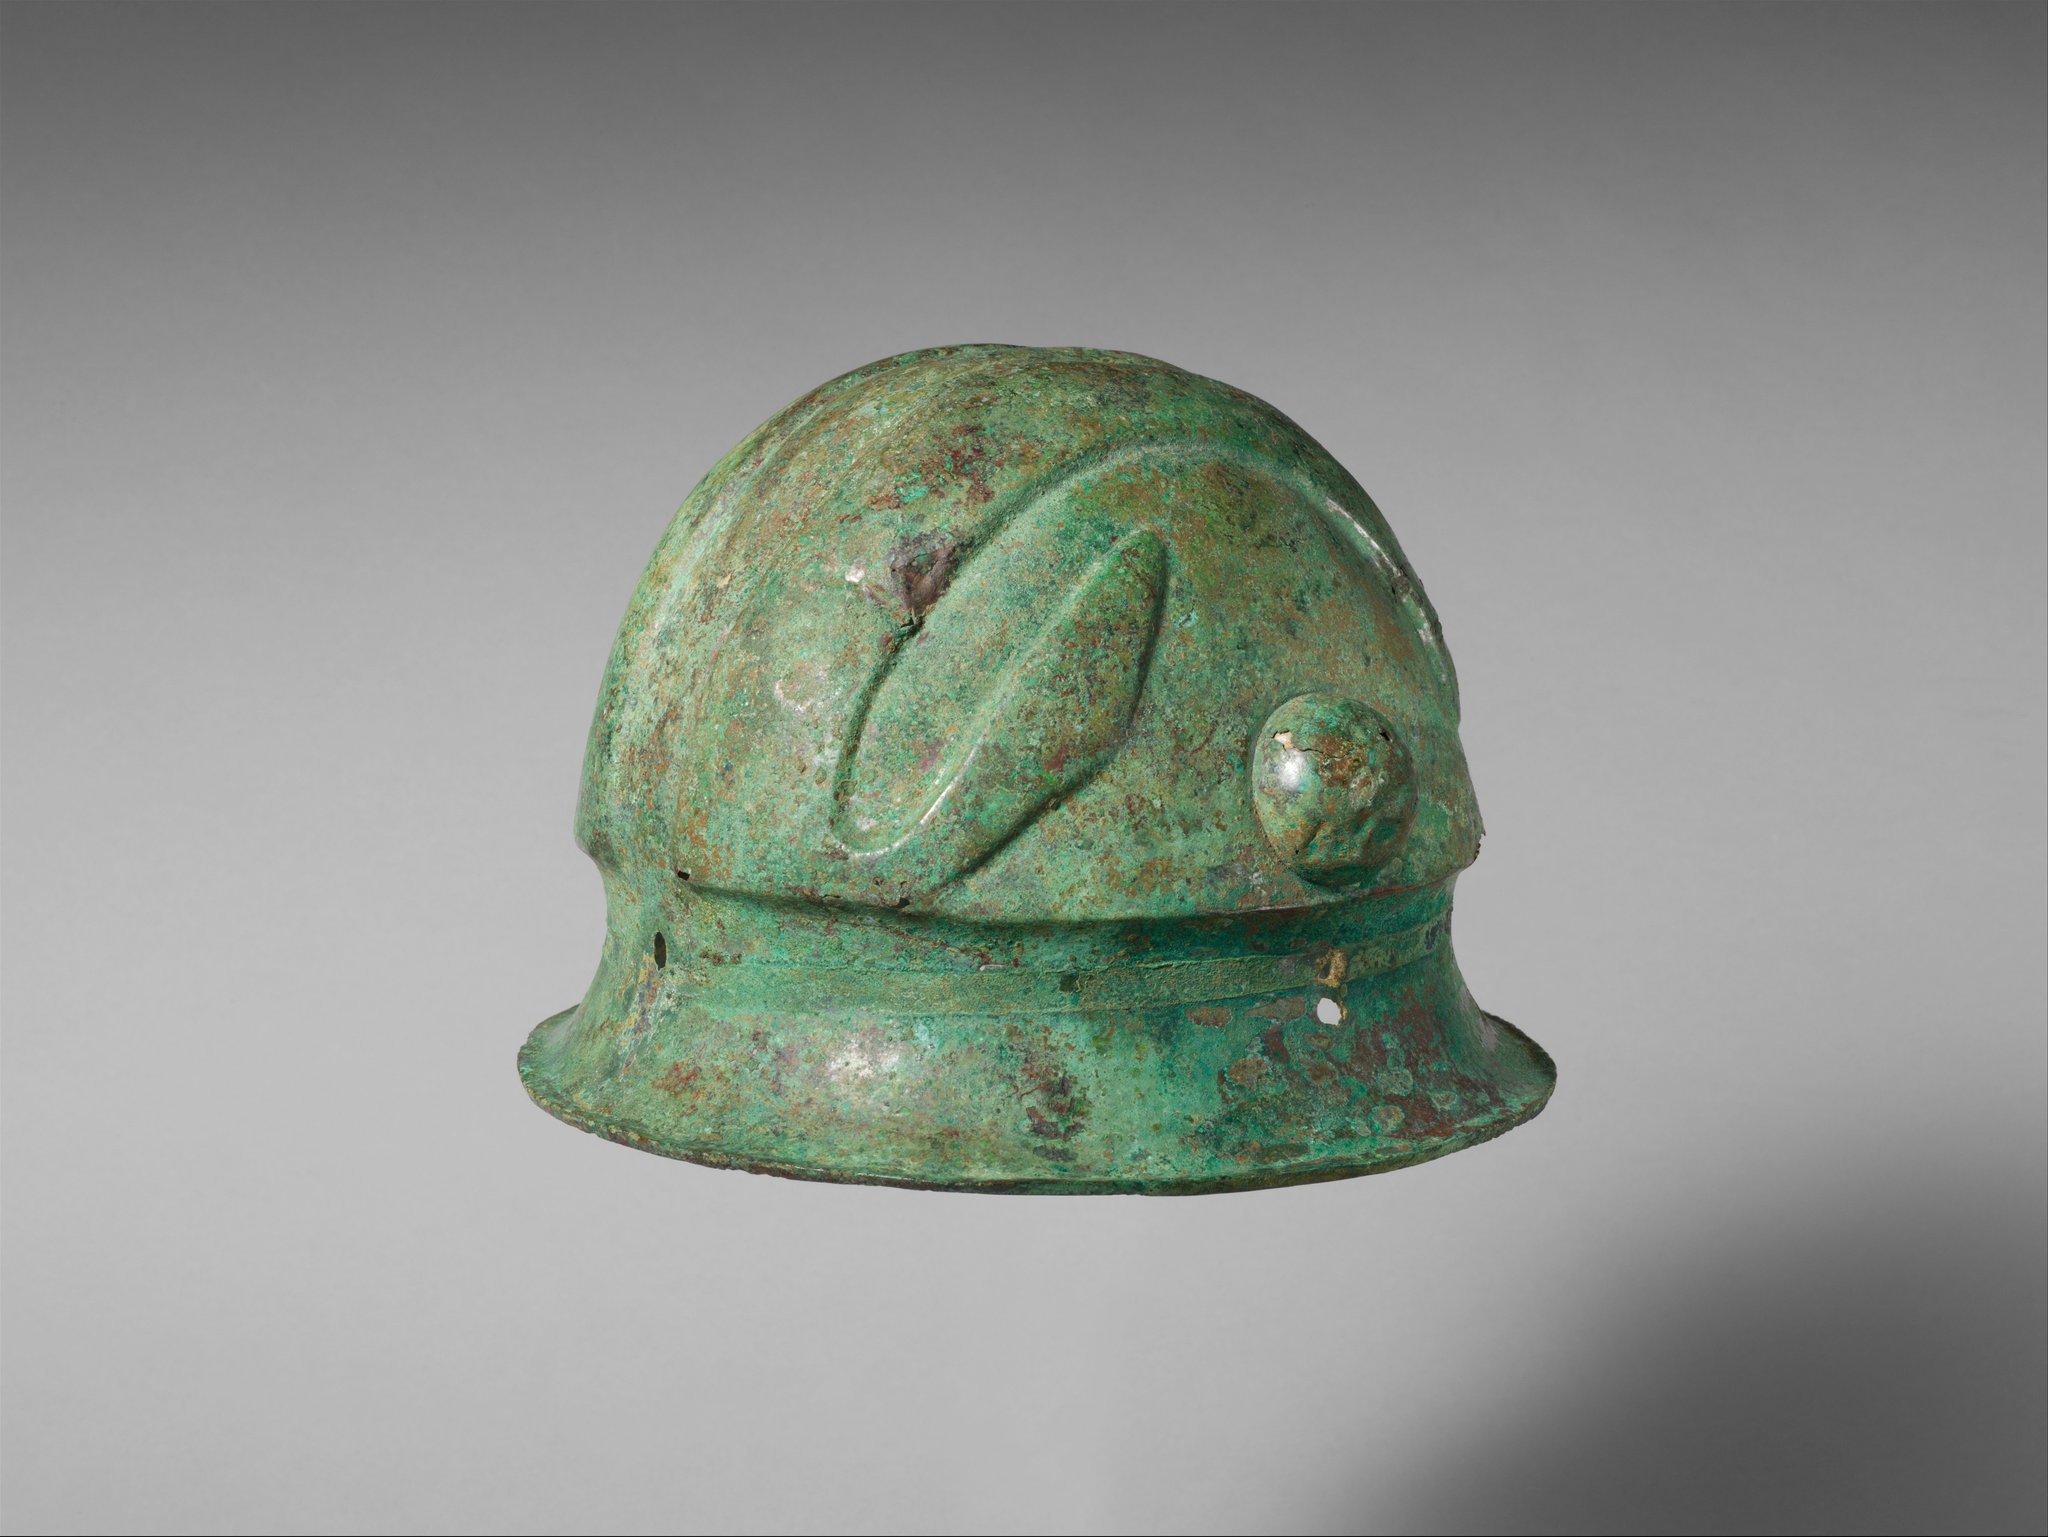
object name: helmet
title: Bronze helmet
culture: italic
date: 600-568 BCE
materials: bronze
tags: helmets